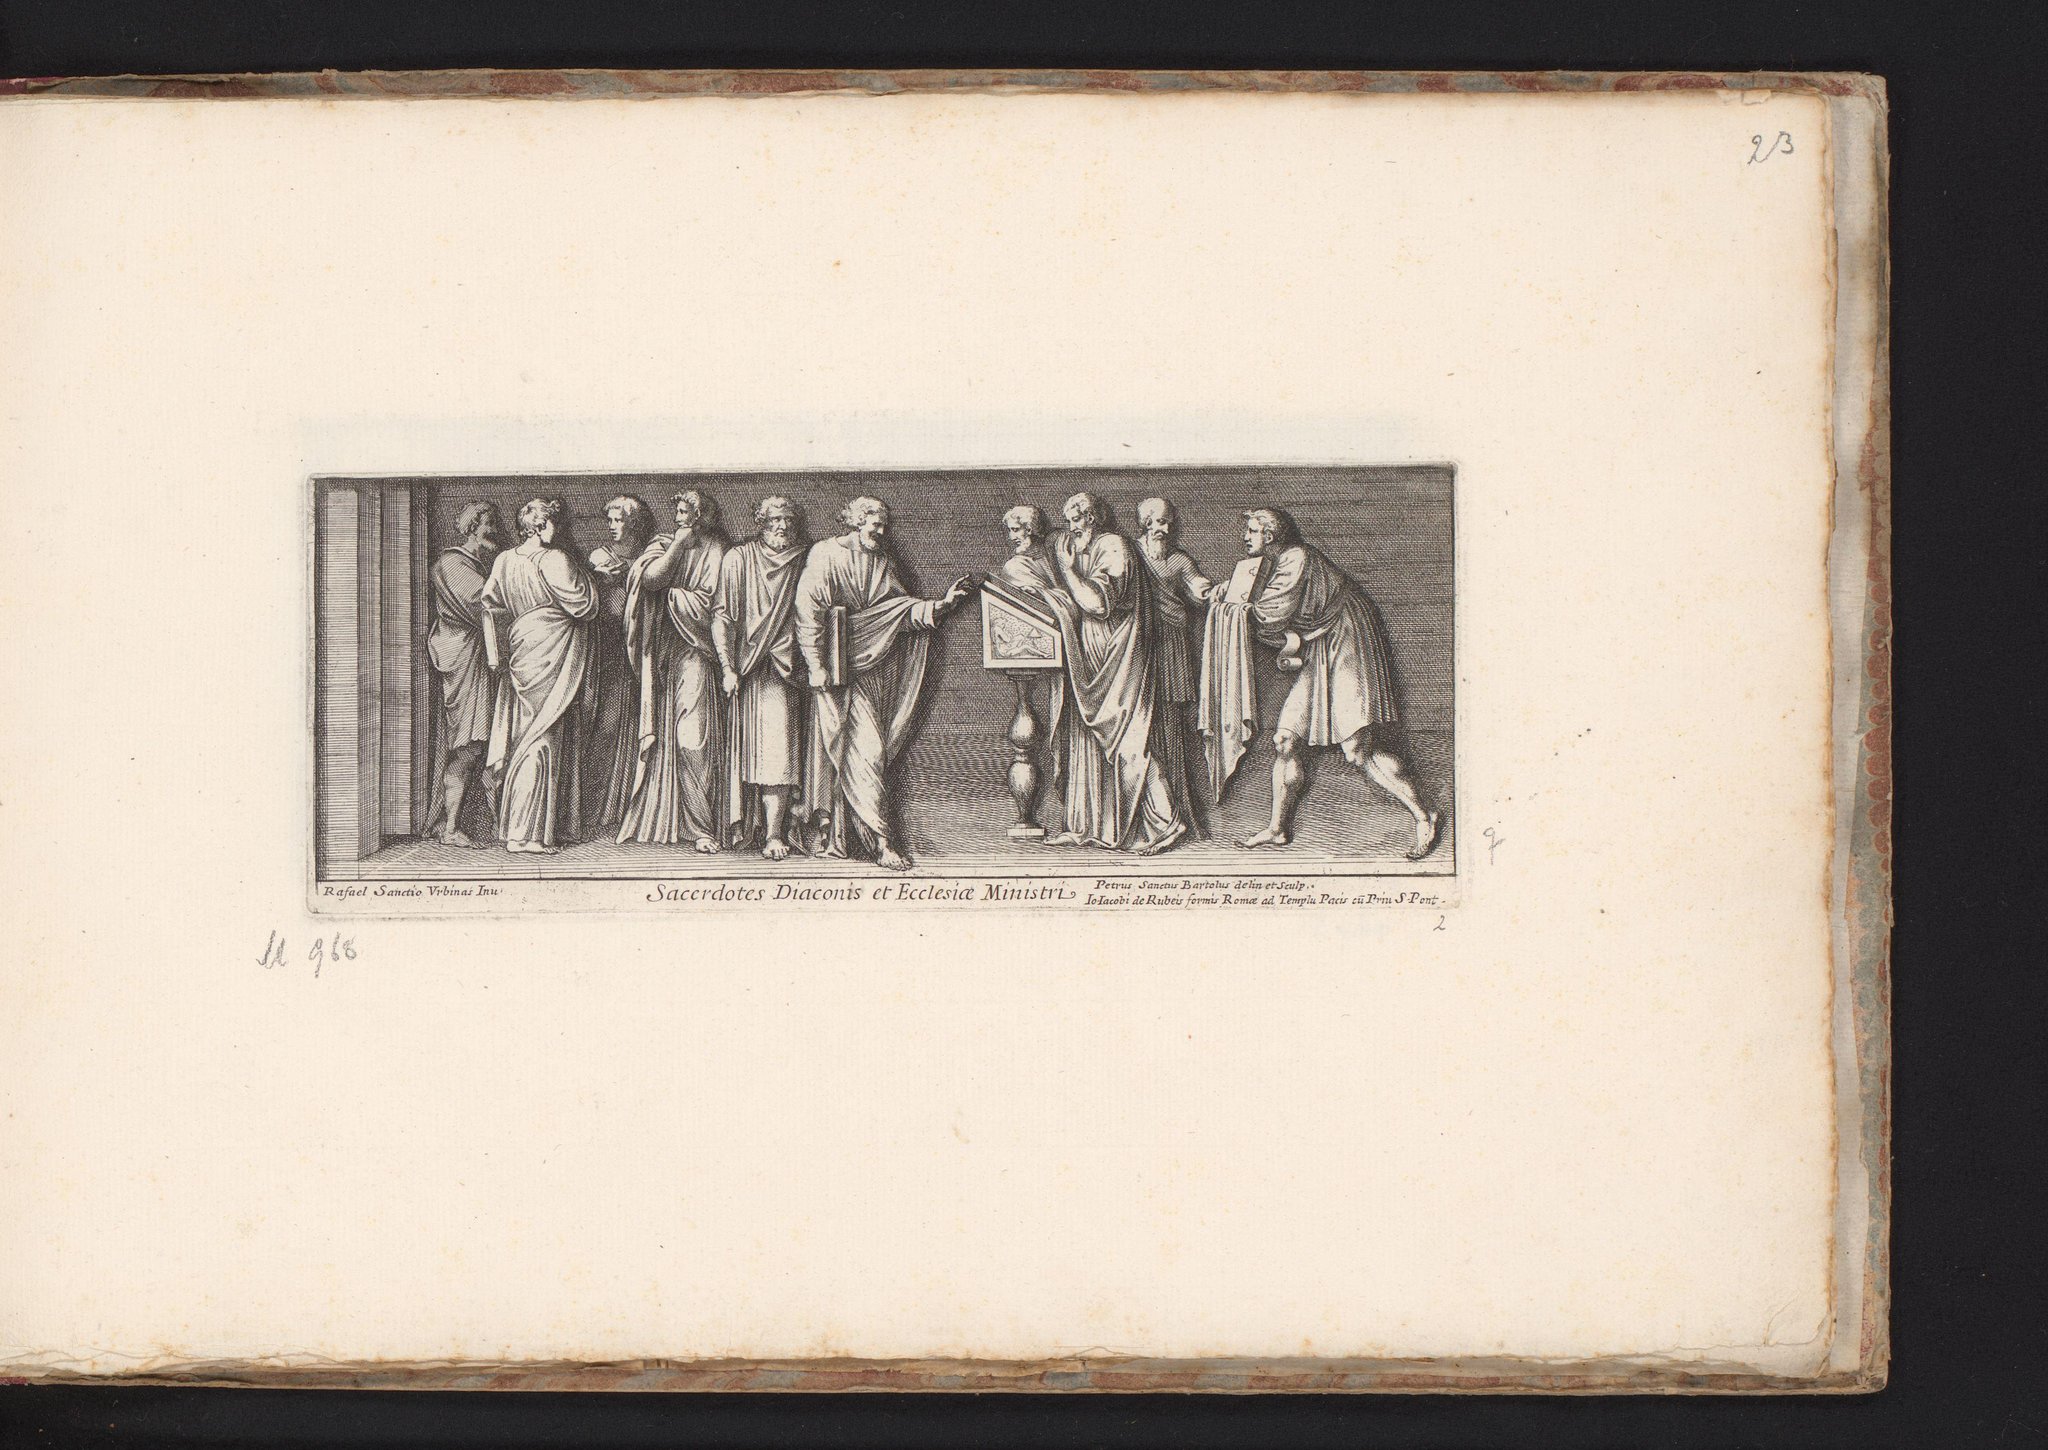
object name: album leaf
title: Paulus in de synagoge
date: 1645-1700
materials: paper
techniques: engraving, etching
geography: vatican city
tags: paul preaches in the synagogue of damascus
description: Prent uit een reeks van 14 prenten (+ titelprent) naar schilderingen door Rafaël in de Stanze di Raffaello in het Apostolisch Paleis in het Vaticaan en naar ontwerpen voor wandtapijten voor de Sixtijnse Kapel door Rafaël.